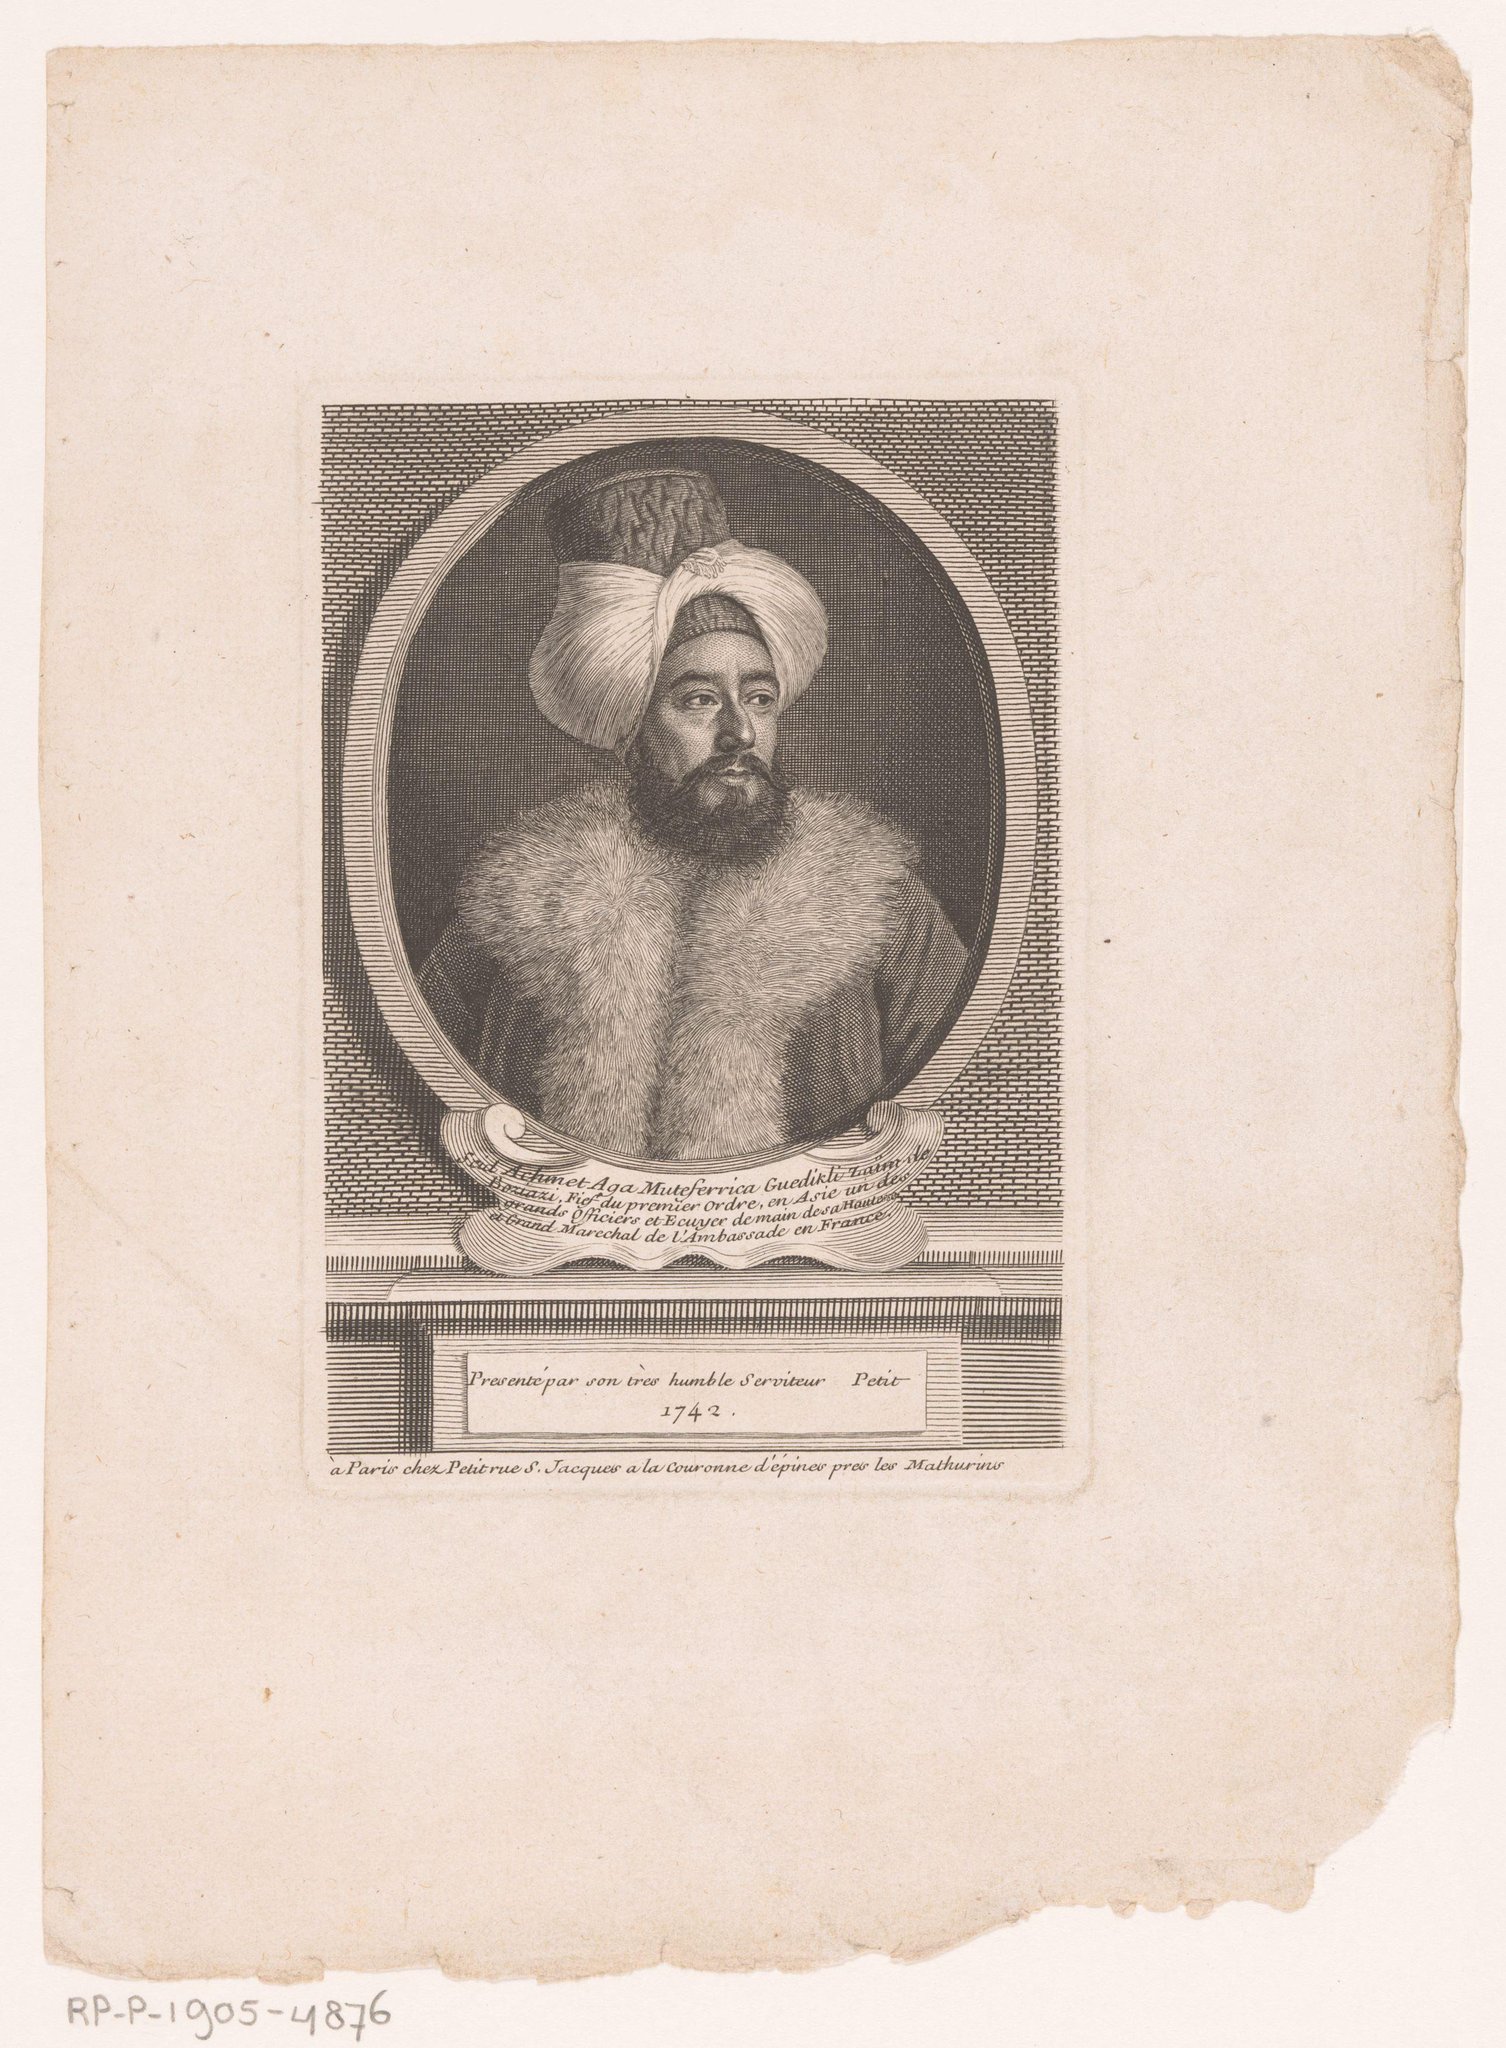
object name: print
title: Portret van Ibrahim Muteferrika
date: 1742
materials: paper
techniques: engraving, etching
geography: paris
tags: ibrahim muteferrika, social sciences, historical persons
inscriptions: collector's mark: Lugt 2228